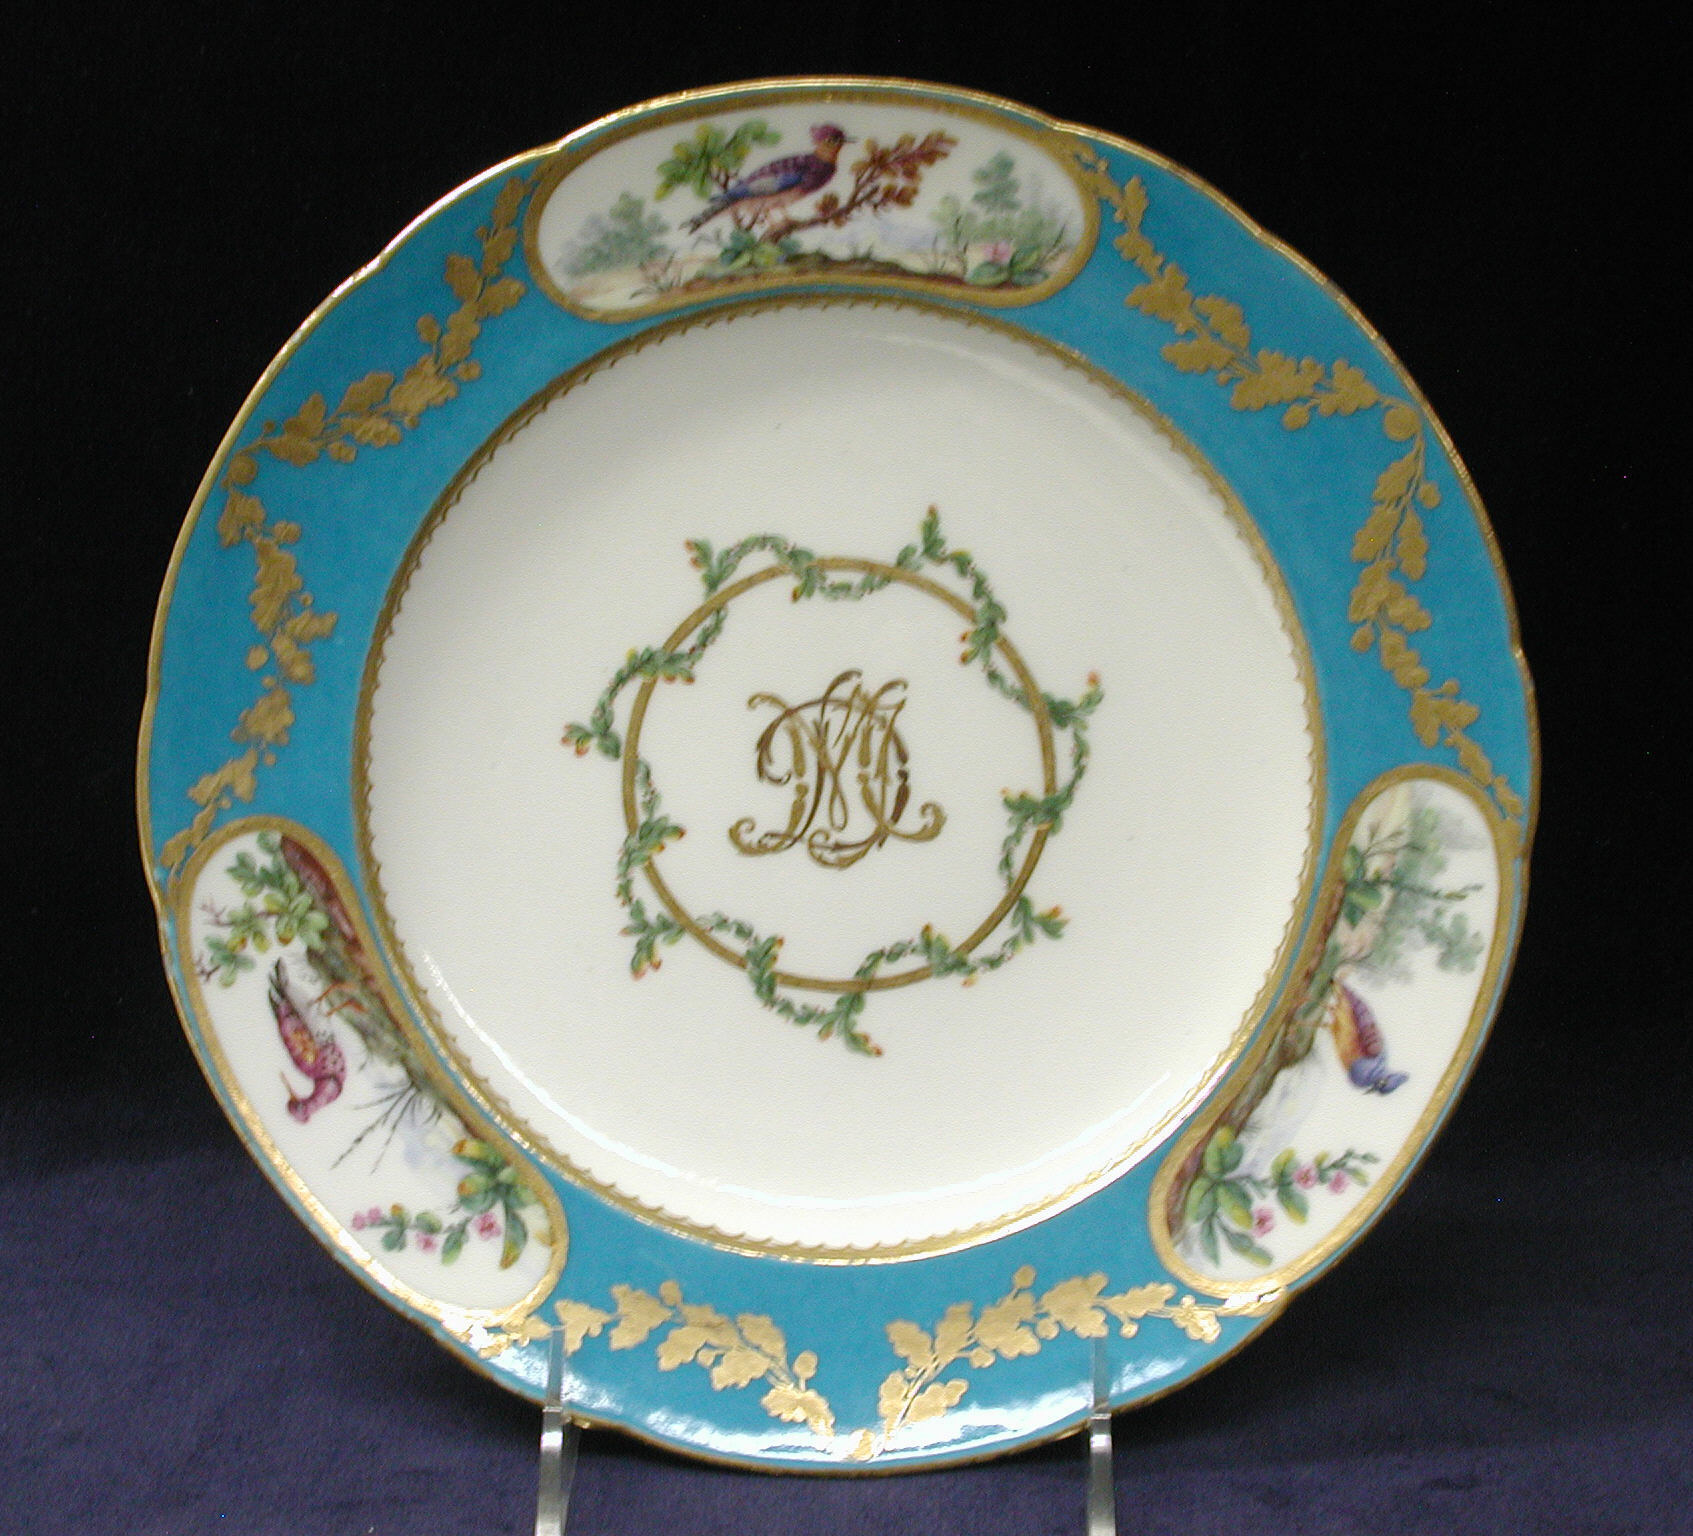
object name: plate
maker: sèvres manufactory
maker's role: manufactory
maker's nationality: french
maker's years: 1740-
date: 1775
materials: soft paste porcelain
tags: birds,insignia